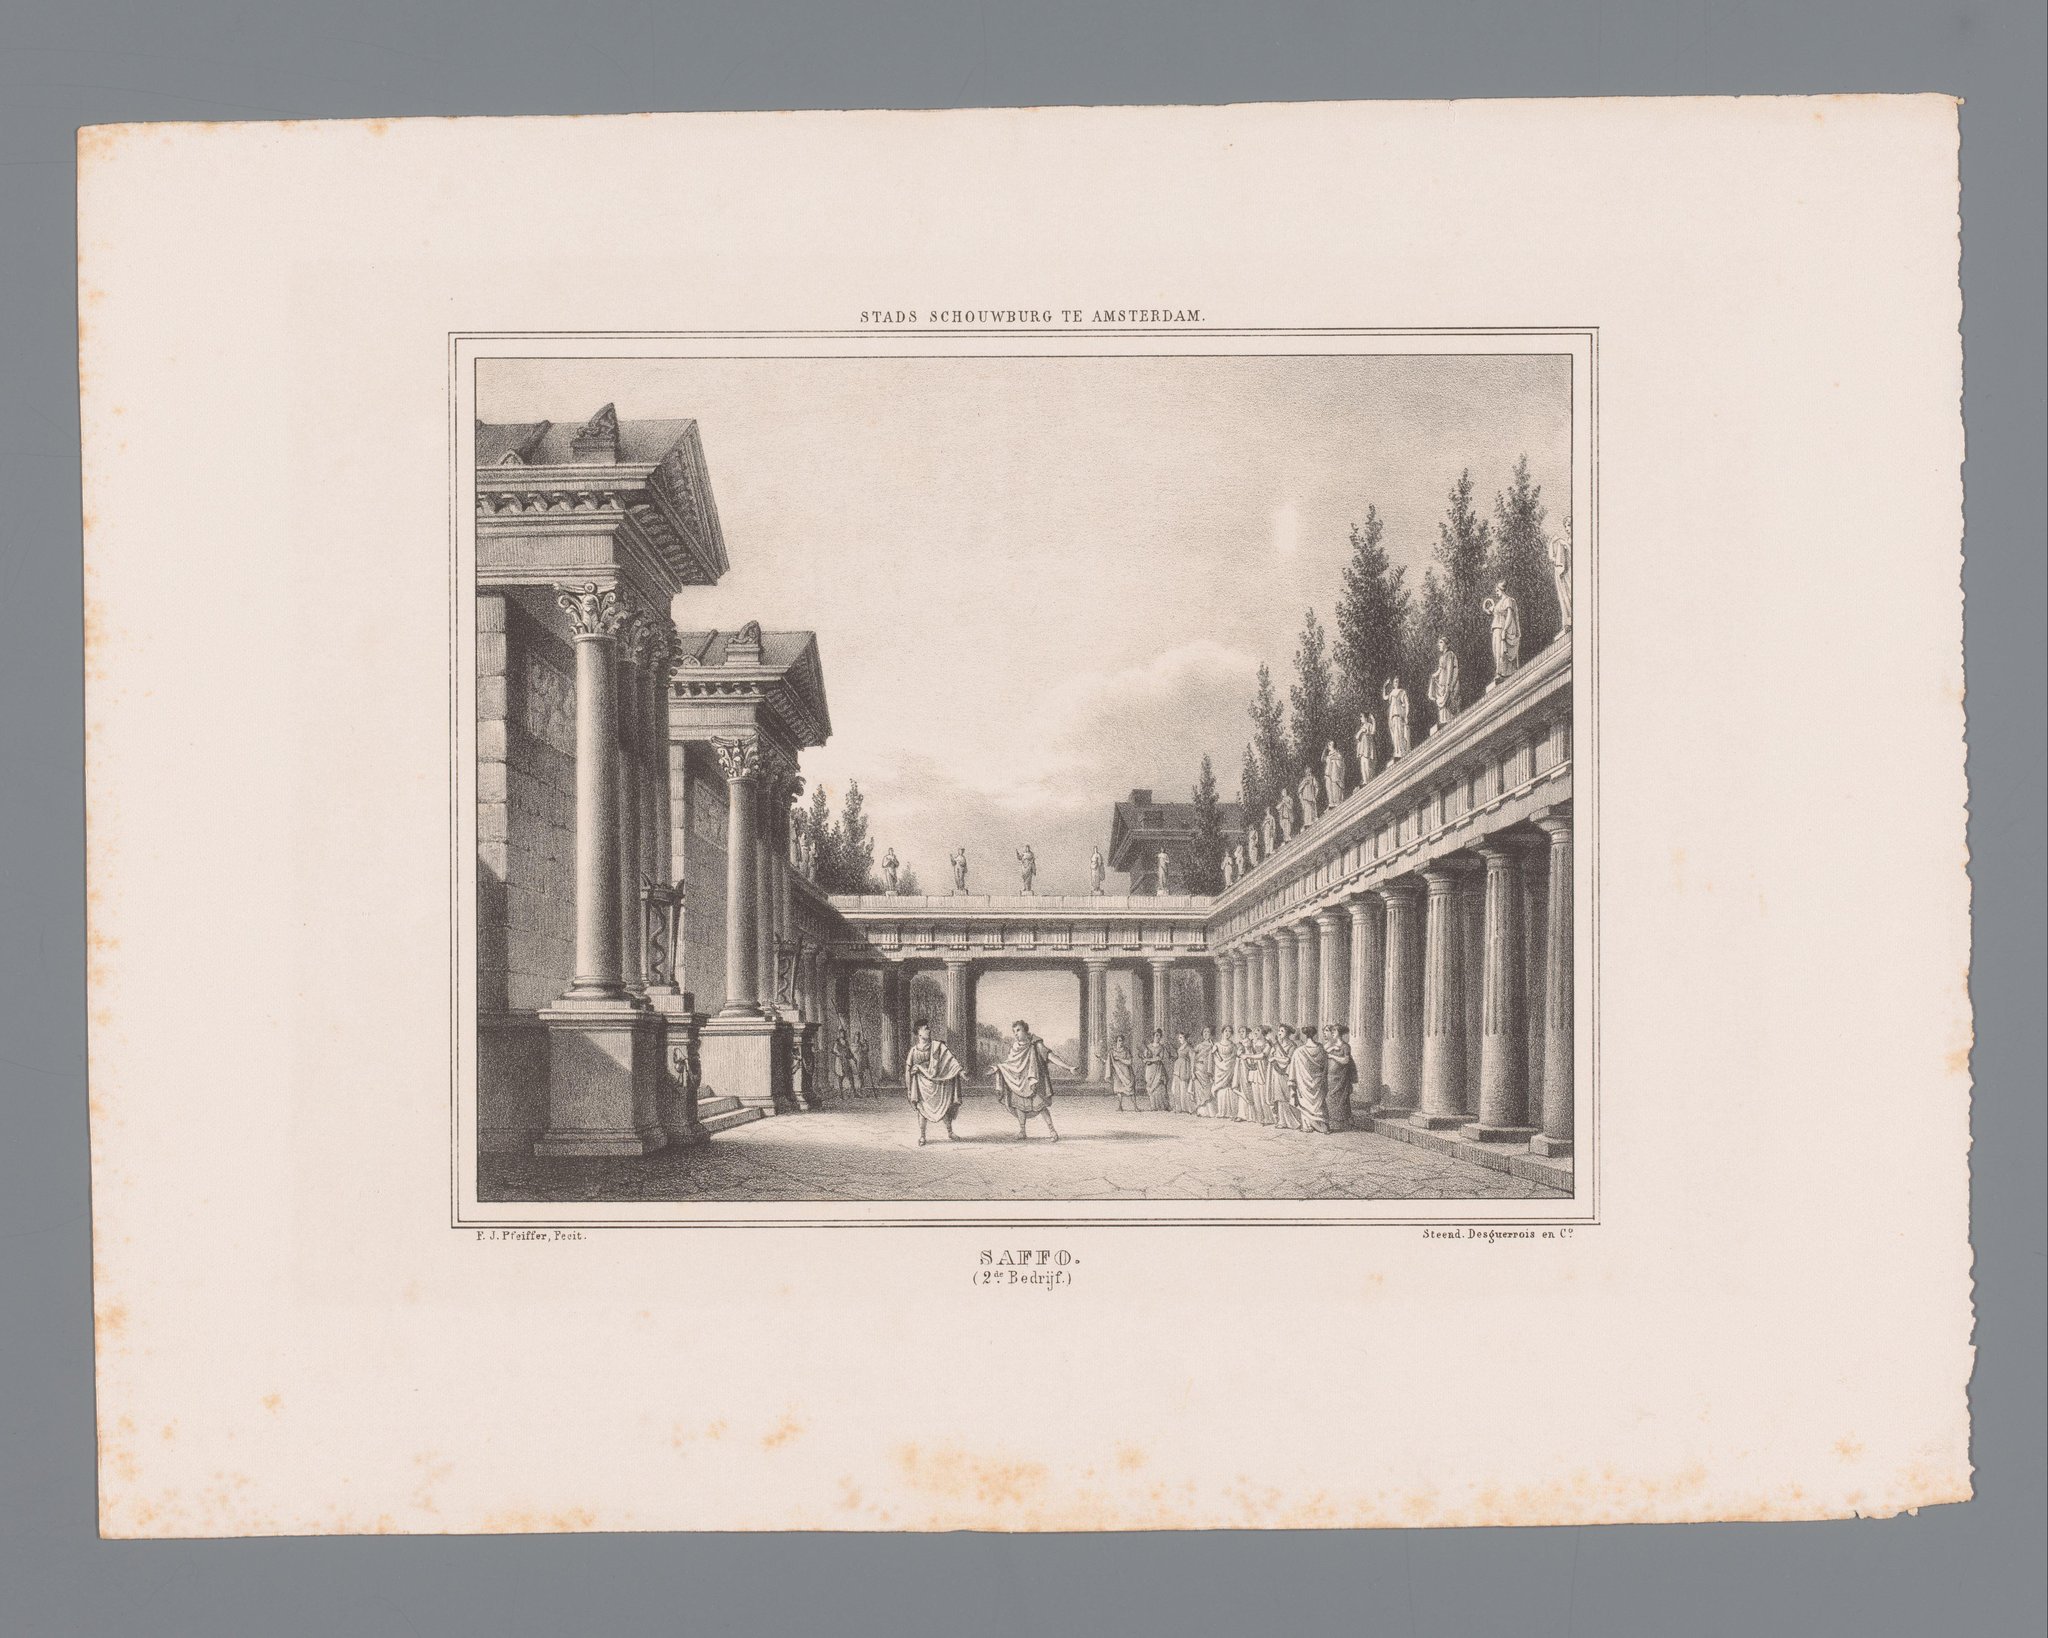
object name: print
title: Tooneel Decoratief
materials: paper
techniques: lithograph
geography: amsterdam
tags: (story of) sappho, the poetess, group of actors, troupe; actors on the stage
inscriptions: collector's mark: Lugt 2228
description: Twee mannen staan voor elkaar in een peristilium voor een tempel. Rechts kijkt een groep vrouwen toe. Onderdeel van een omslag met een serie van zeven lithografieën van operascènes opgevoerd in de stadsschouwburg te Amsterdam.